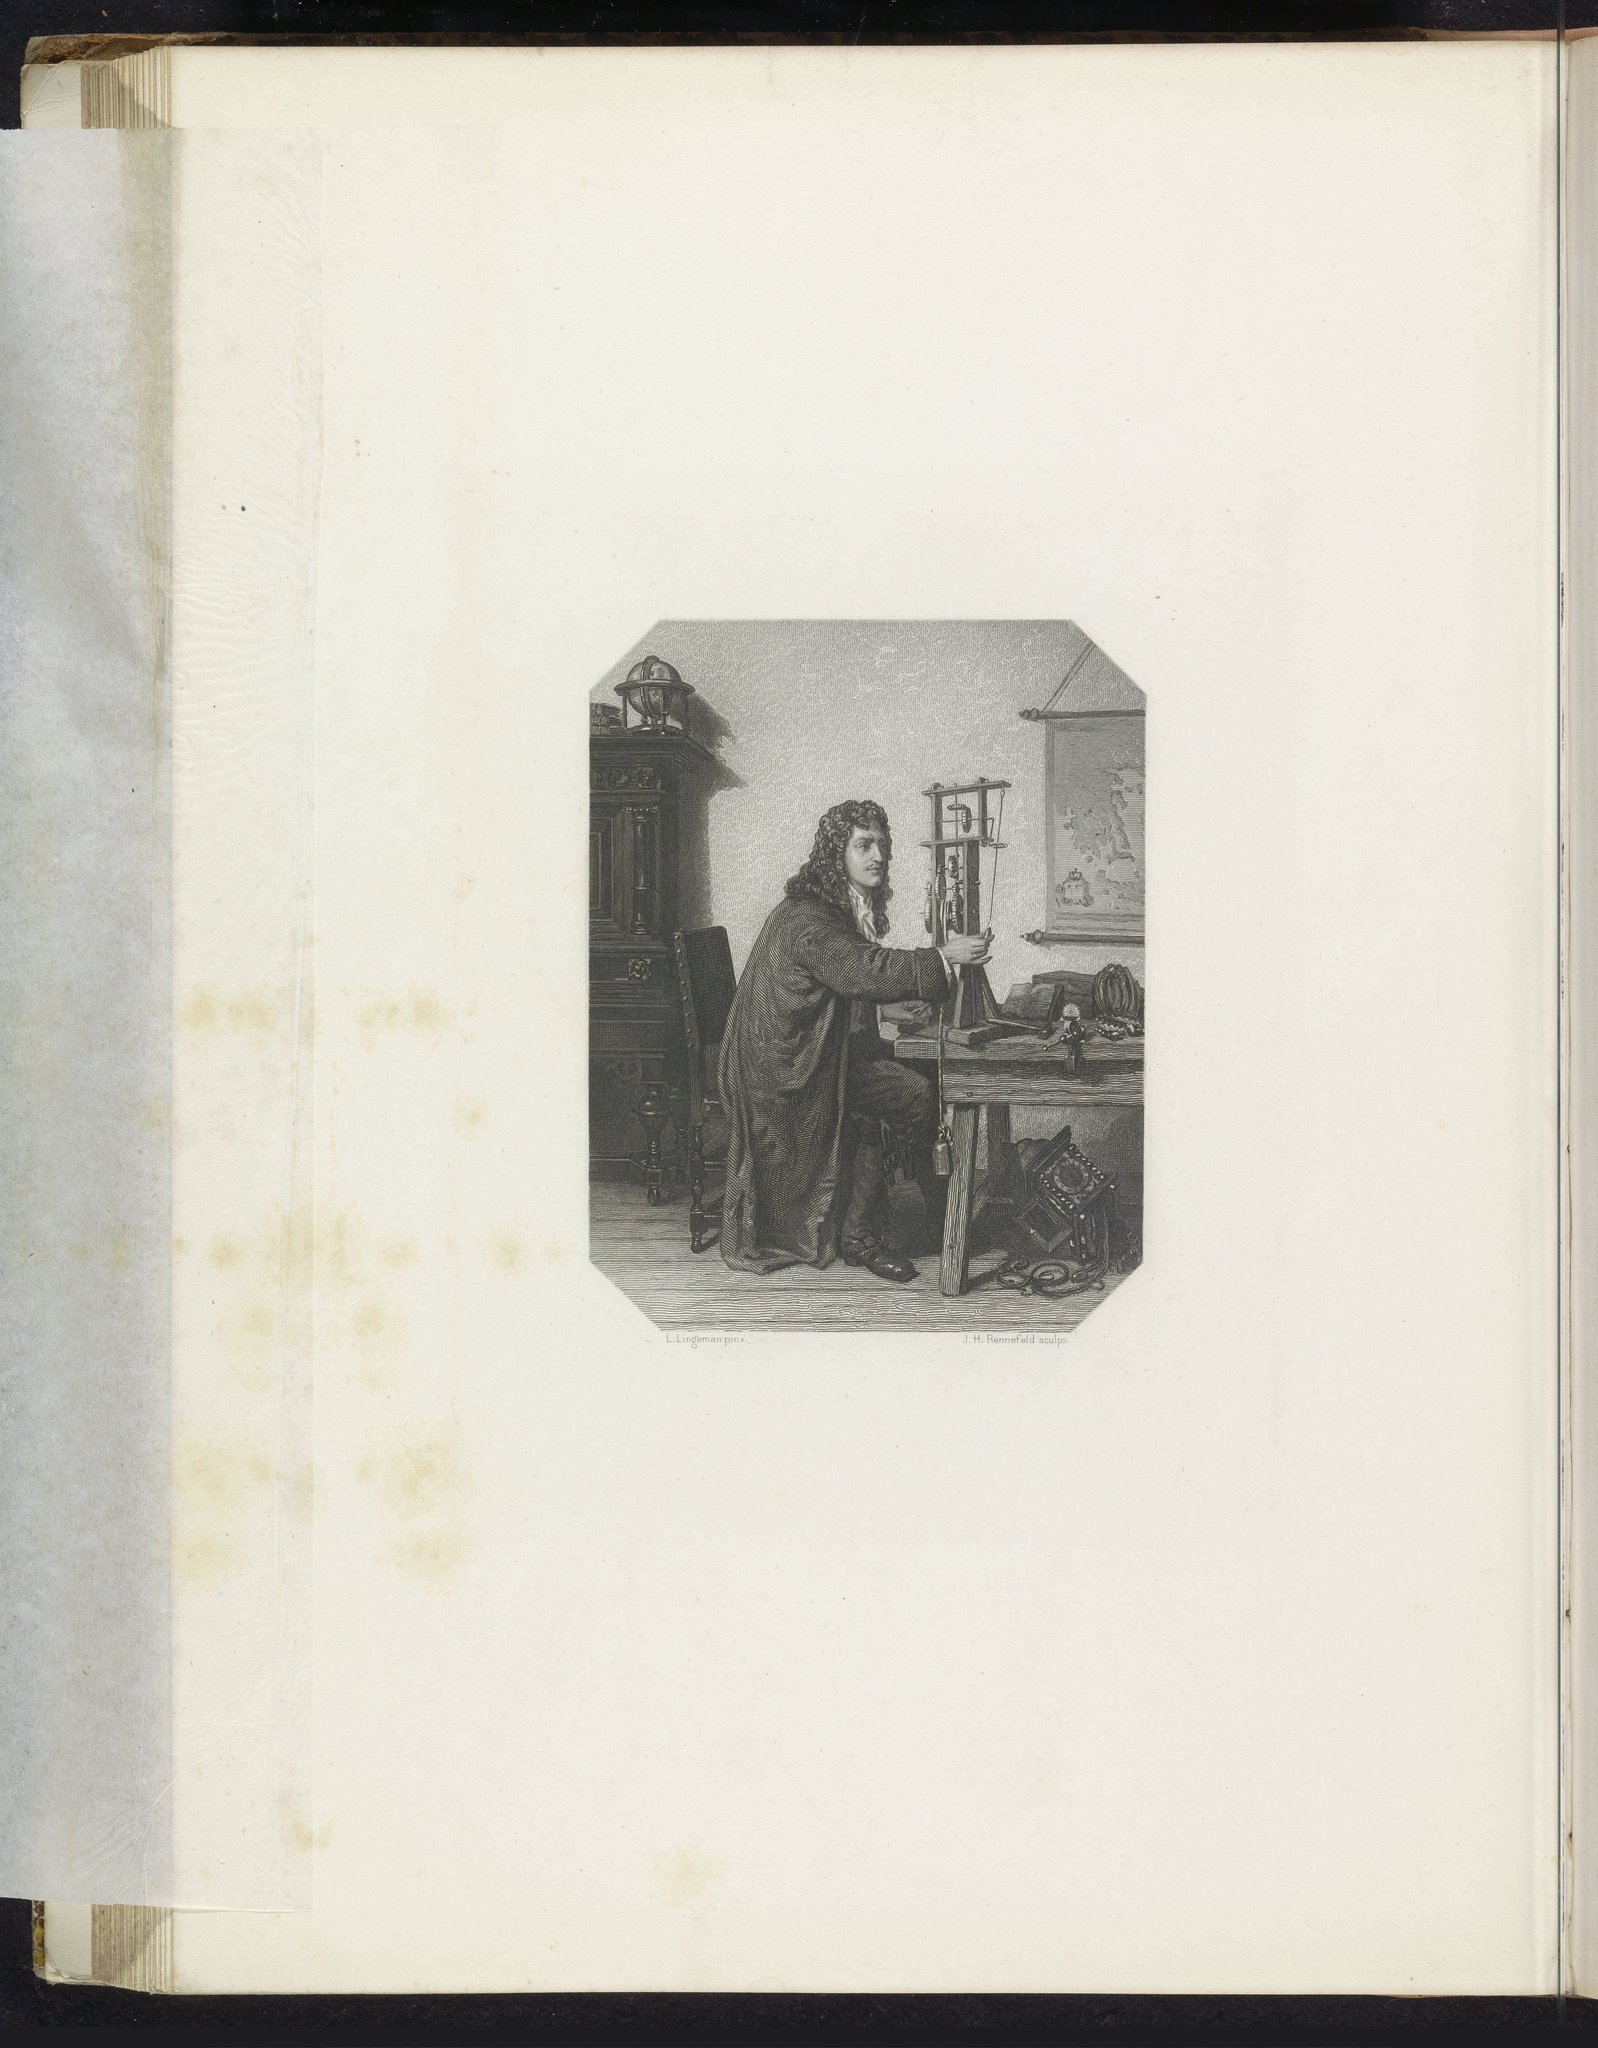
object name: history print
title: Christian Huygens, 1656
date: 1865-1870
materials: paper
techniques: engraving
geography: netherlands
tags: draughtsman, physicist, christiaan huygens (ii), invention, discovery ~ science and technology, watchmaker, clockmaker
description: Christian Huygens, werkend aan een uurwerk, 1656. Onderdeel van de groep staalgravures naar de schilderijen van de Historische Galerij der Maatschappij Arti et Amicitiae.